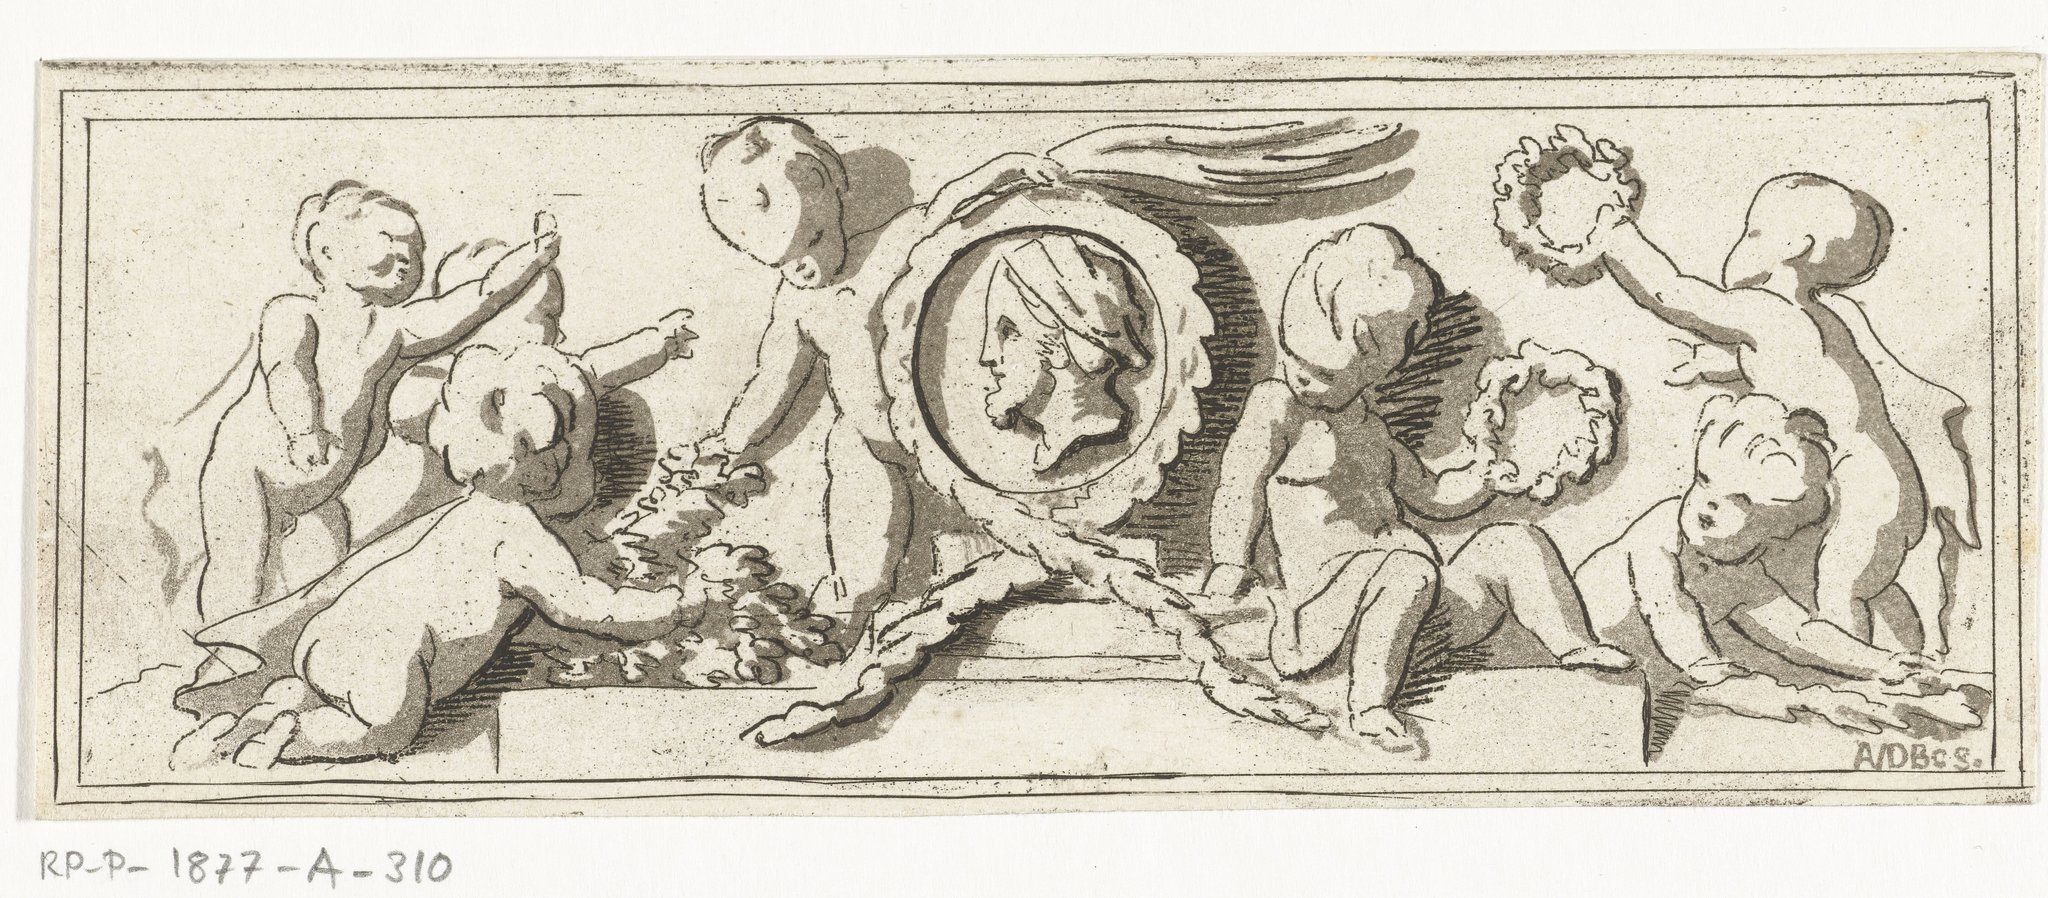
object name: print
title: Fries met putti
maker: anthonie van den bos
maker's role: draughtsman, print maker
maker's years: 1763-1838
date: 1778-1838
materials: paper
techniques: aquatint, etching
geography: netherlands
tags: cupids: 'amores', 'amoretti', 'putti'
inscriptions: collector's mark: Lugt 2228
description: Zeven putti met bloemenkransen op een fries. In het midden een medaillon met een mannenportret en profiel.